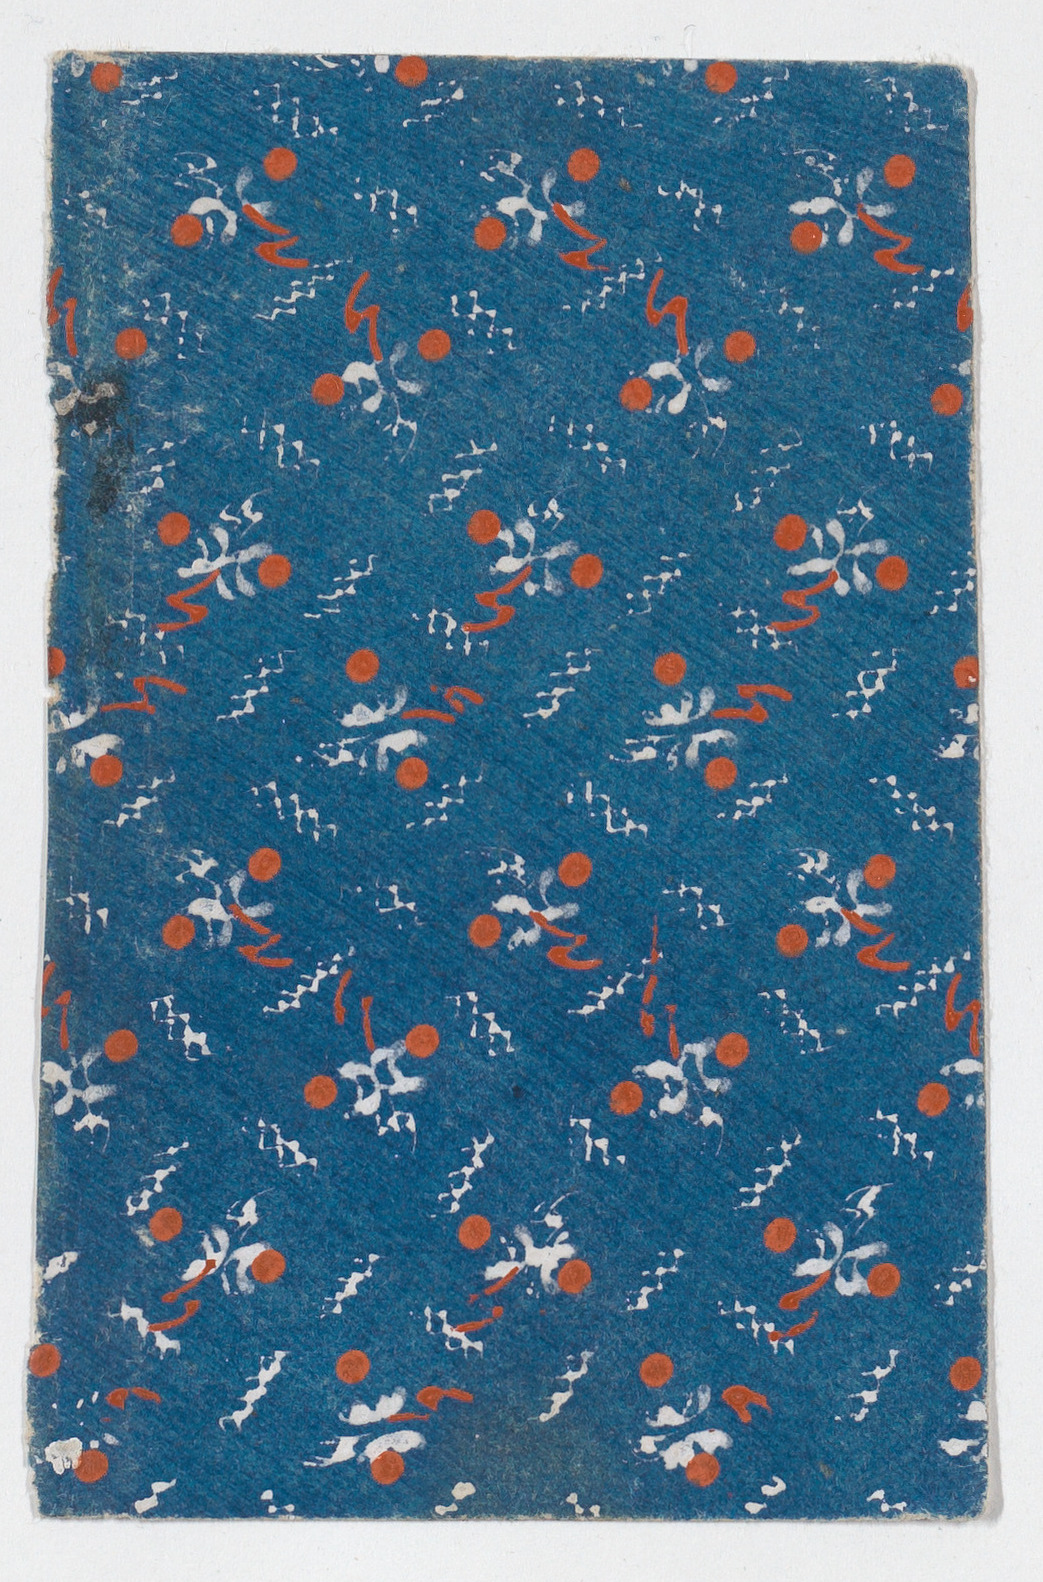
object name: print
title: Sheet with abstract pattern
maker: Anonymous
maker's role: artist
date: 1801-1900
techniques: relief print